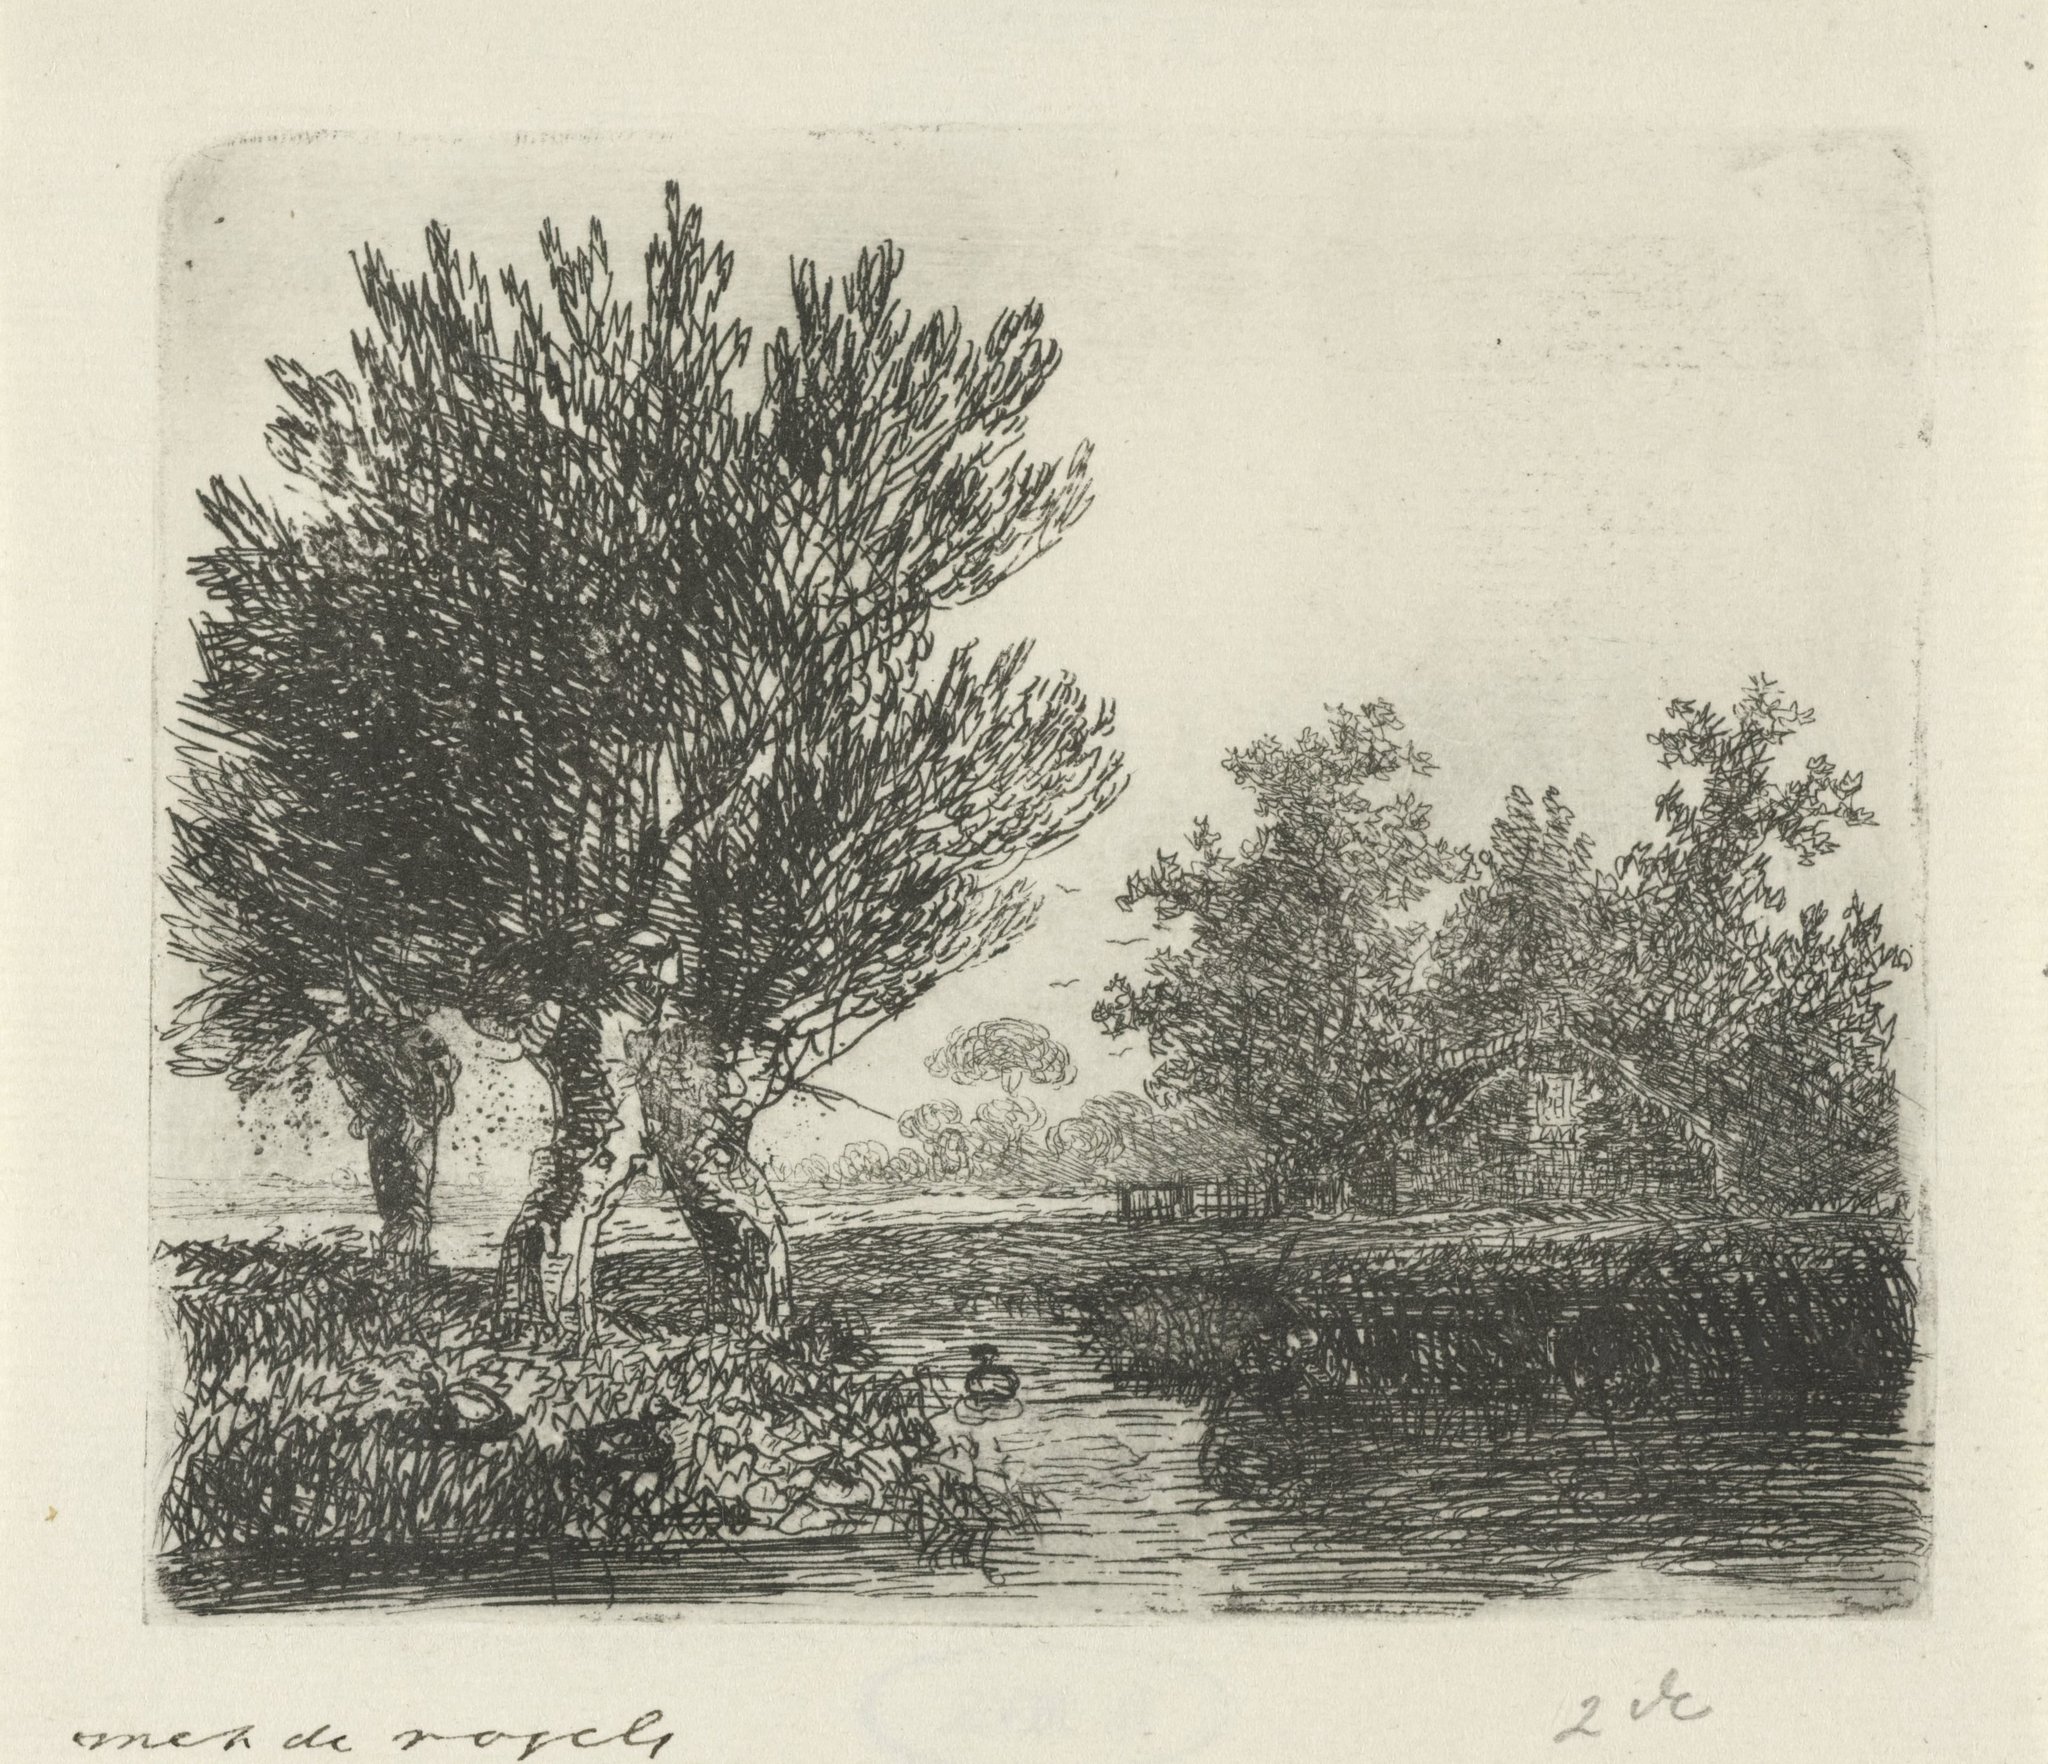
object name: print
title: Drie knotwilgen aan een waterkant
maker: hermanus jan hendrik van rijkelijkhuysen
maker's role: painter, print maker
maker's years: 1813-1883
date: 1823-1883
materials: paper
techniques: drypoint, etching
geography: utrecht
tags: brook, trees: willow, farm or solitary house in landscape, water-birds: duck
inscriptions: collector's mark: Lugt 2228, inscription: ‘met de vogels’, inscription: ‘2 de’